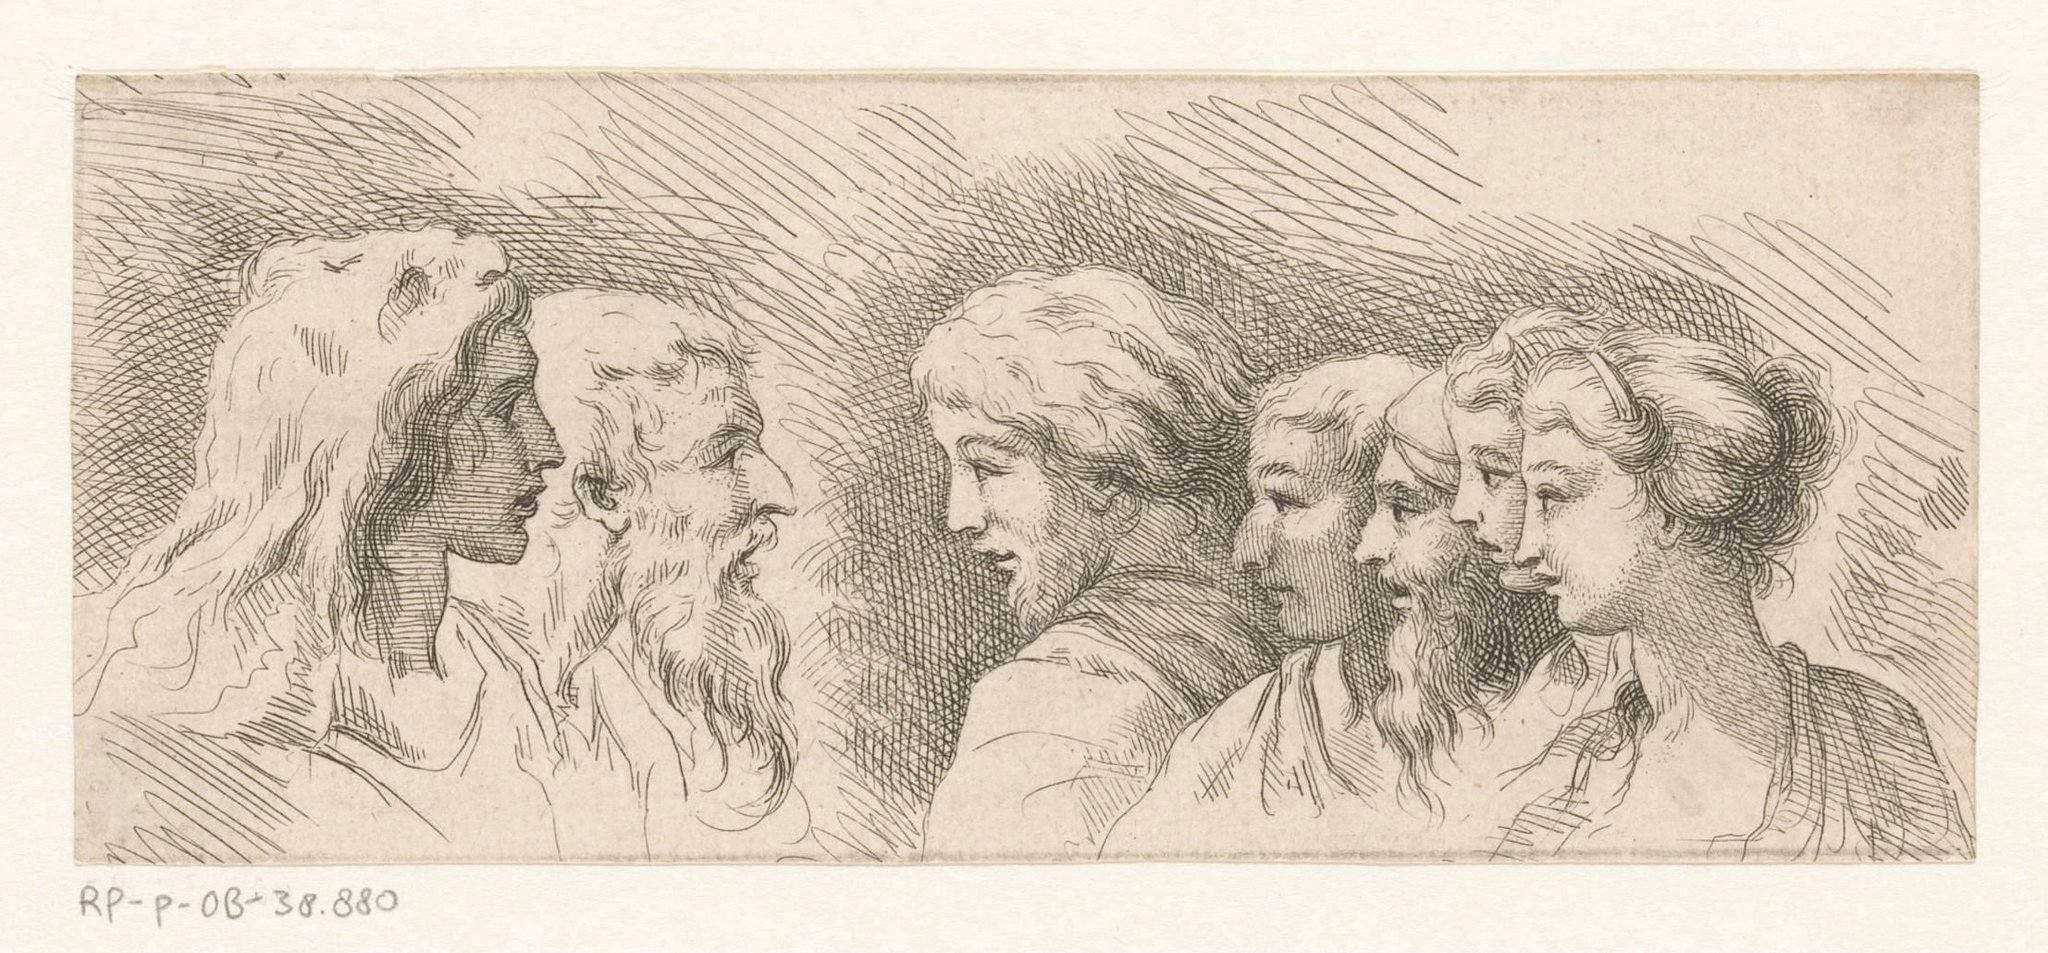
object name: print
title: Bustes van zeven mannen en vrouwen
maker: Anonymous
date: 1650-1749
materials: paper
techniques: etching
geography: italy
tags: adolescent, young woman, maiden, adult man, old man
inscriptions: collector's mark: Lugt 240